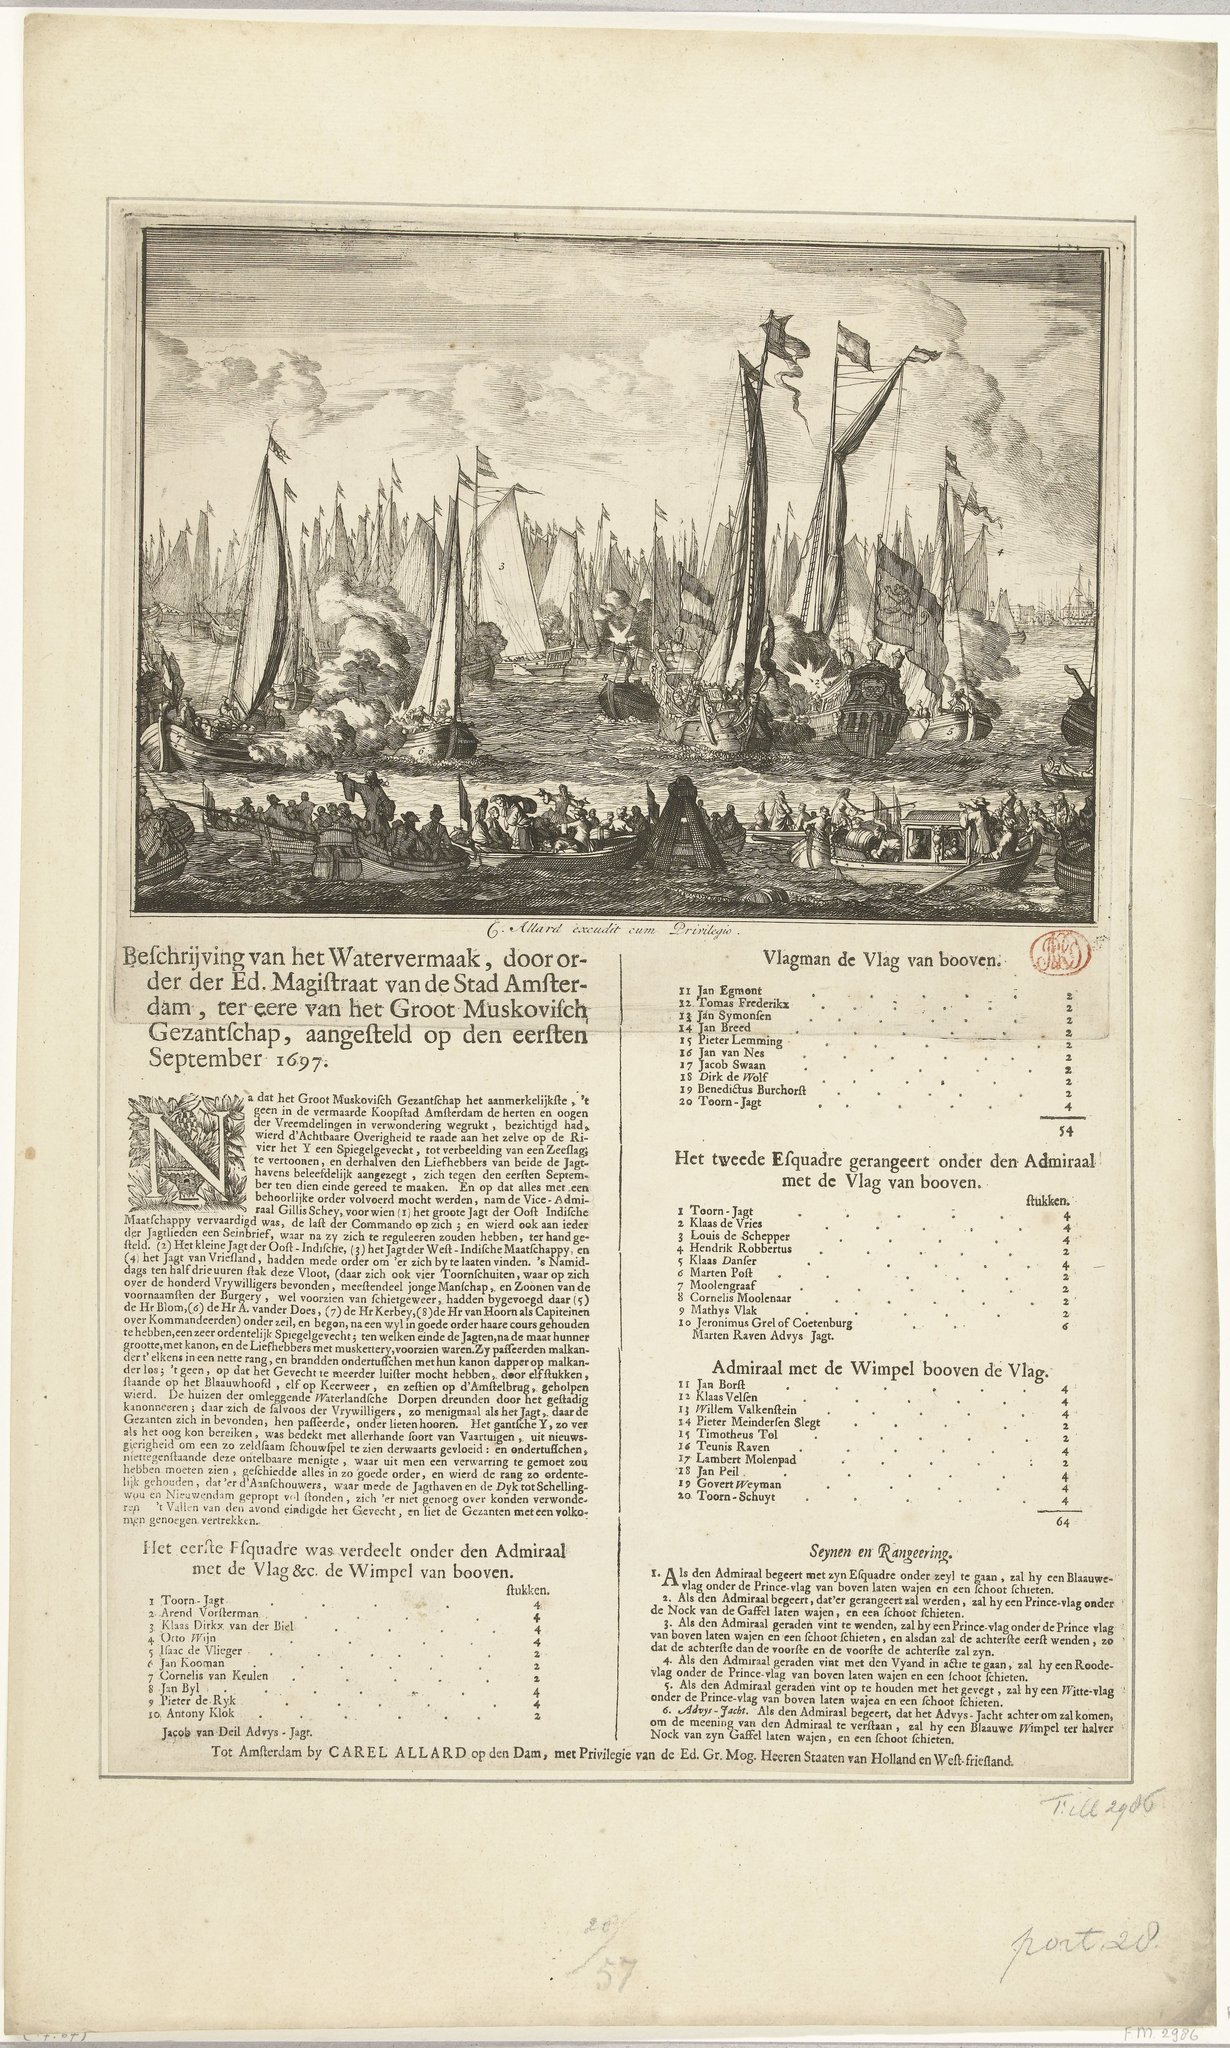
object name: history print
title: Scheepsgevecht op het IJ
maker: carel allard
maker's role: print maker, publisher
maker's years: 1648-1709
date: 1697-1699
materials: paper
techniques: etching, letterpress printing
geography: amsterdam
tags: peter i de grote (tsaar van rusland), triumphal entry and public reception, pageant, 'entrée solennelle', 'joyeuse entrée', improvised and unusual traffic on the water - cc - more than one ship, amsterdam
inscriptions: collector's mark: Lugt 195, collector's mark: Lugt 2228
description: Scheepsgevecht op het IJ in Amsterdam ter ere van het bezoek van Peter I de Grote. Rechts op de achtergrond de Admiraliteitswerf. Met een beschrijving van het gevecht en de verschillende schepen in het Nederlands, in twee kolommen.